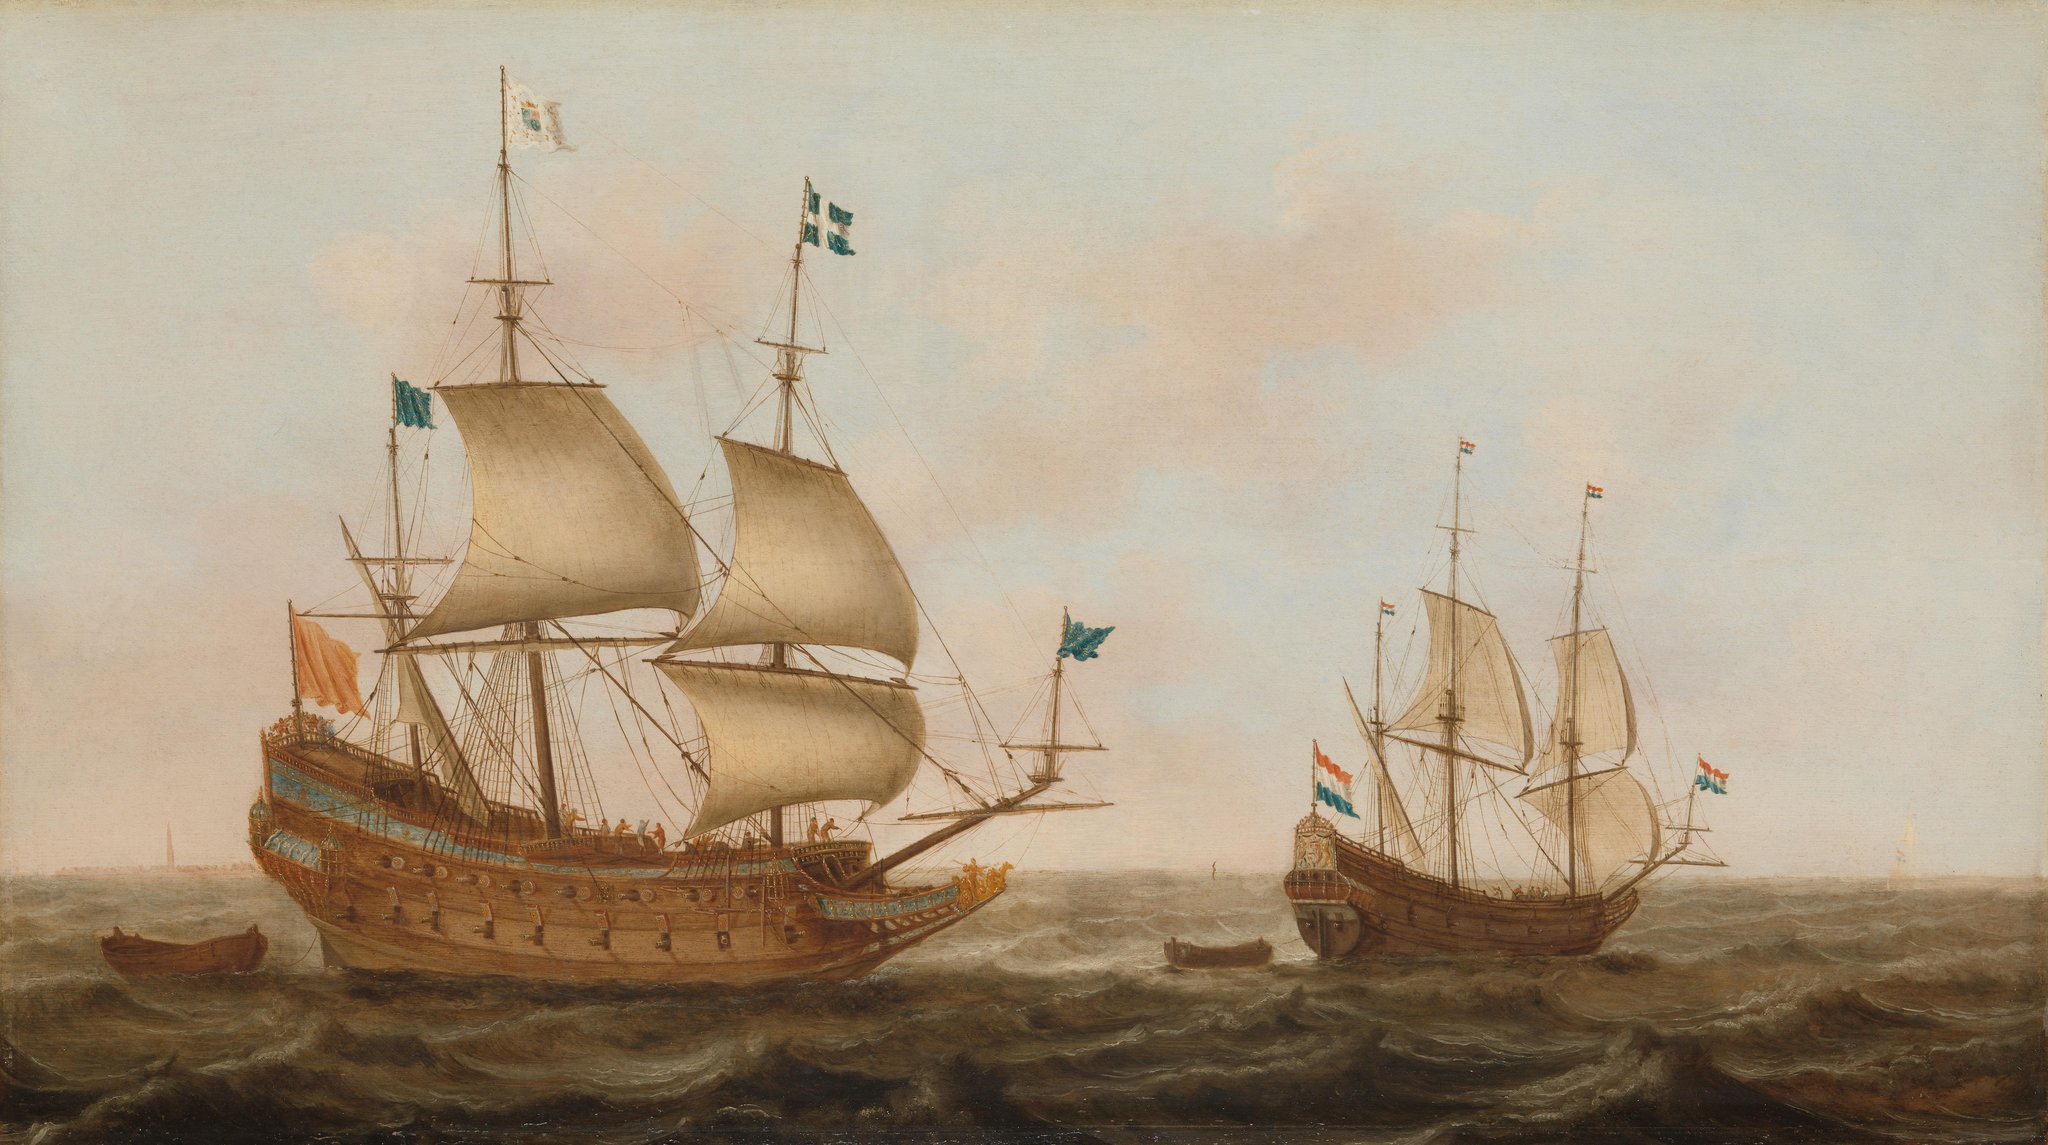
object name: painting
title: A Warship Built for France and a Dutch Yacht under Sail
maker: jacob gerritz loef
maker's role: painter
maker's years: 1606-1670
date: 1635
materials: oil, panel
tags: lodewijk xiii (koning van frankrijk), ship's portrait (+ propulsion of vehicle, ship, etc. by wind), navy (+ sailing-ships), netherlands, france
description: Een Frans oorlogsschip, in 1626 op last van Lodewijk XIII op een Hollandse werf gebouwd, stevent onder geleide van een kleiner Hollands schip een Hollandse haven binnen.